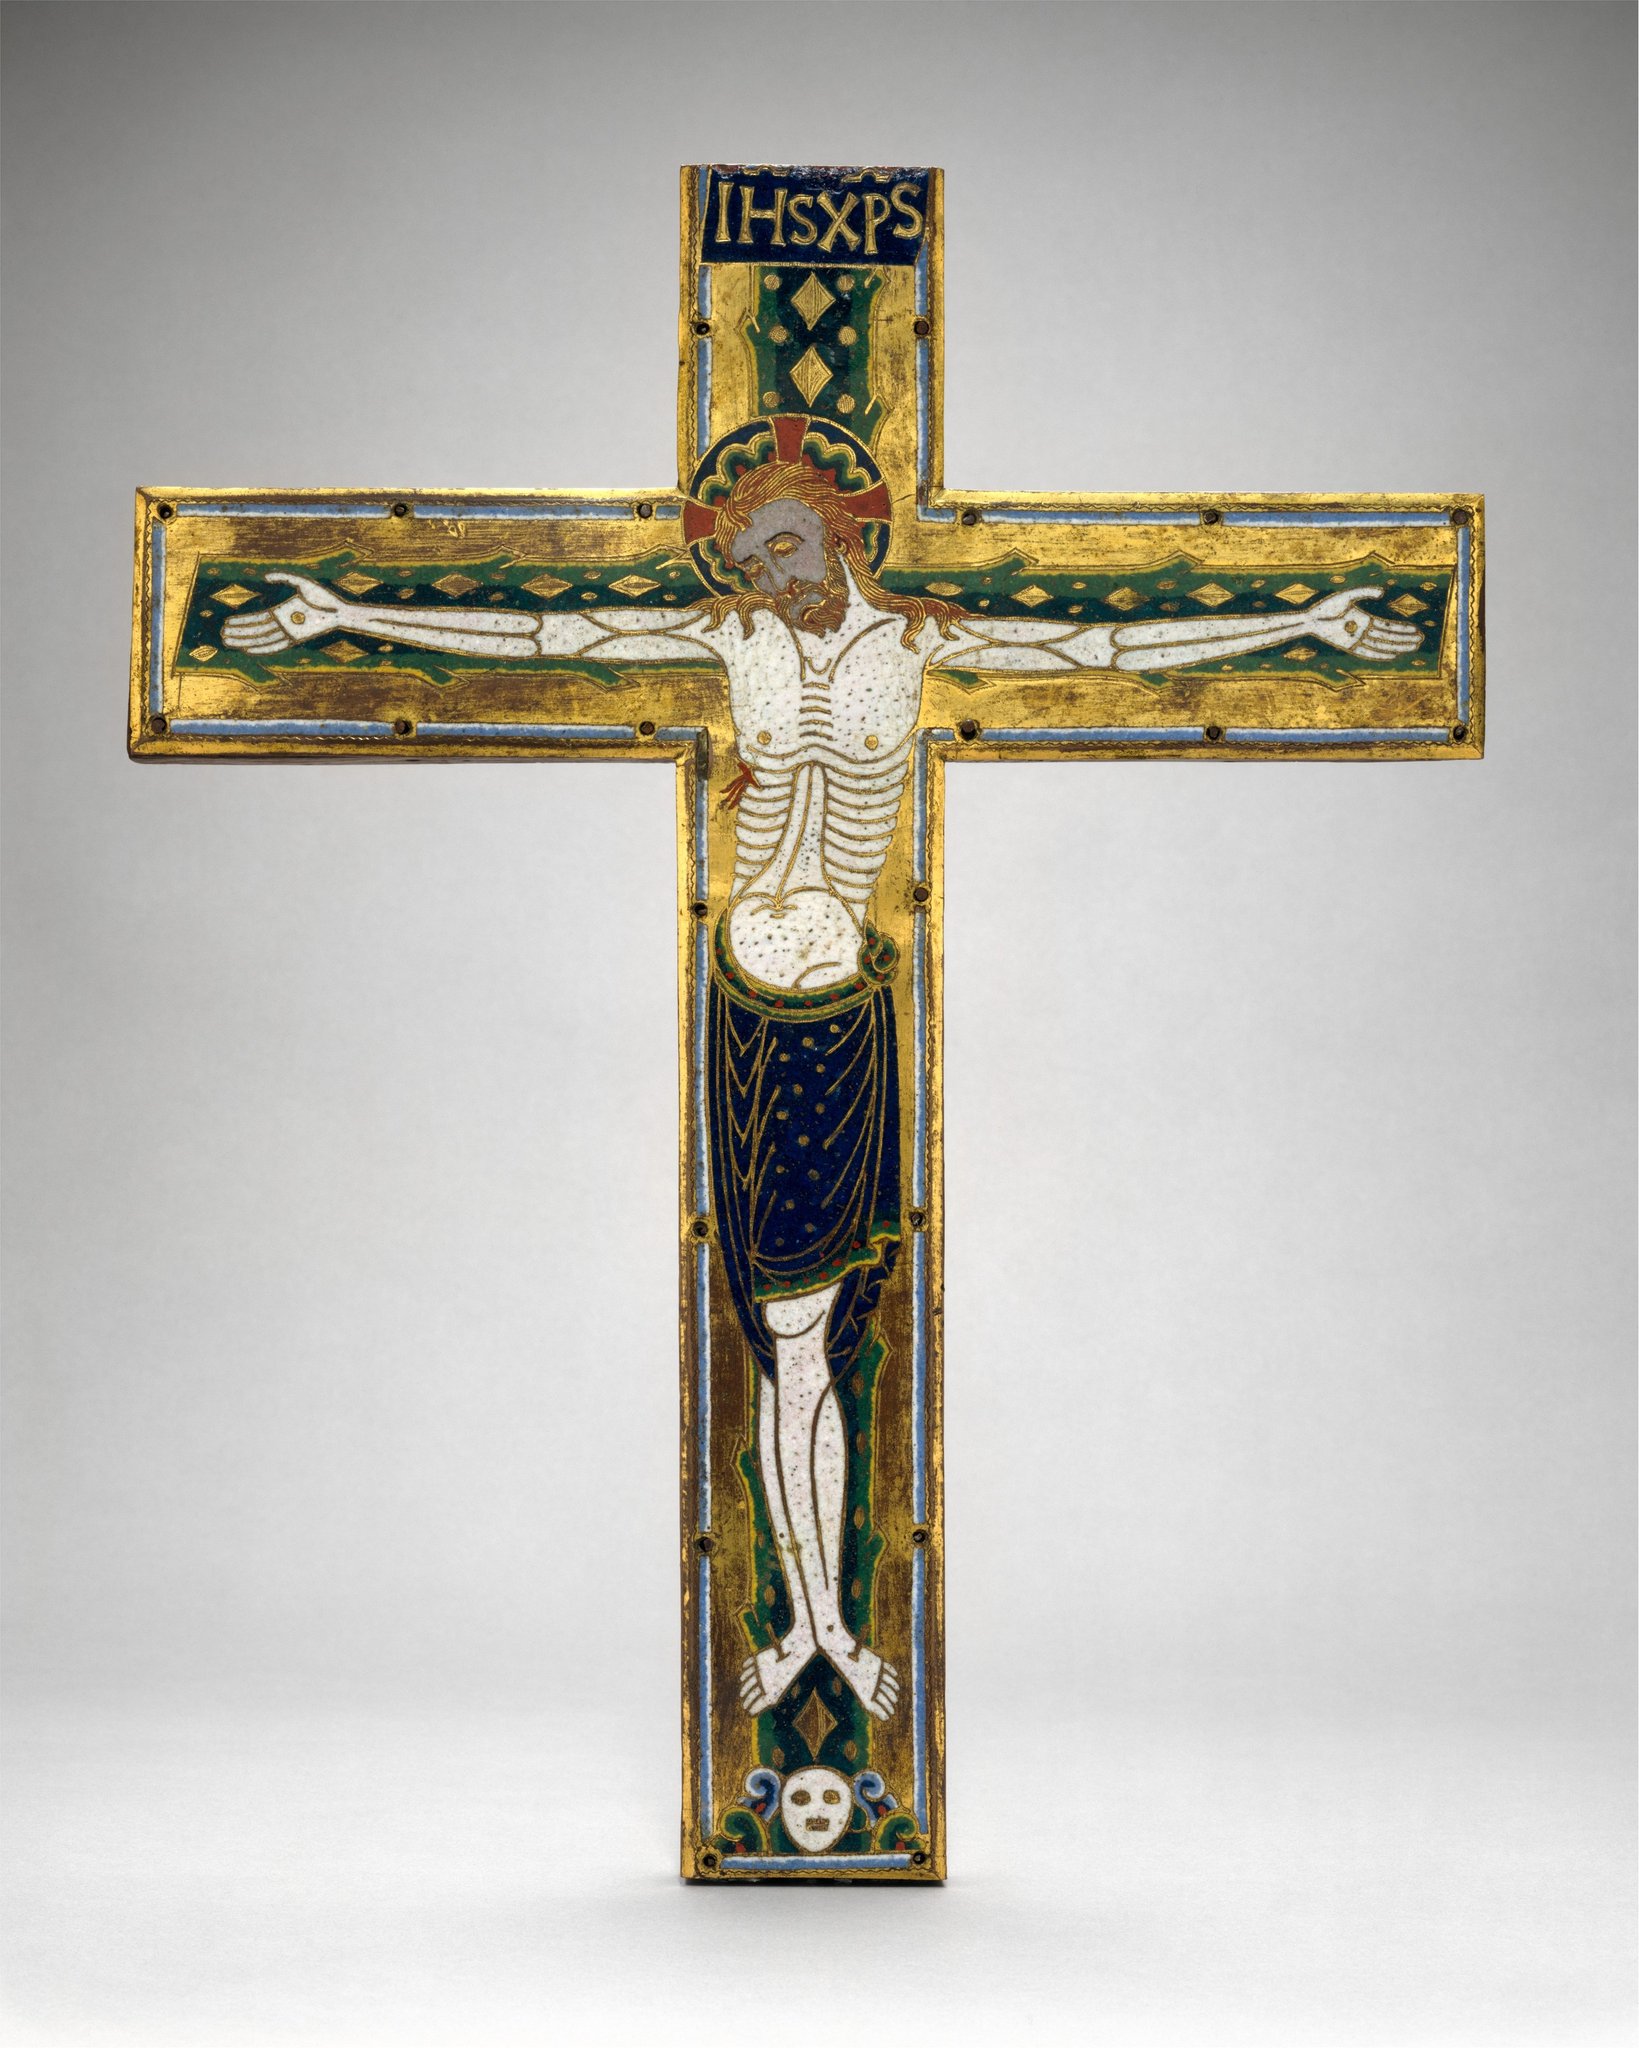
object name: plaque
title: Central Plaque of a Cross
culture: french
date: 1185-1195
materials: copper, enamel, gilt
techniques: enamel, engraving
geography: france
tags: christ,crucifixion